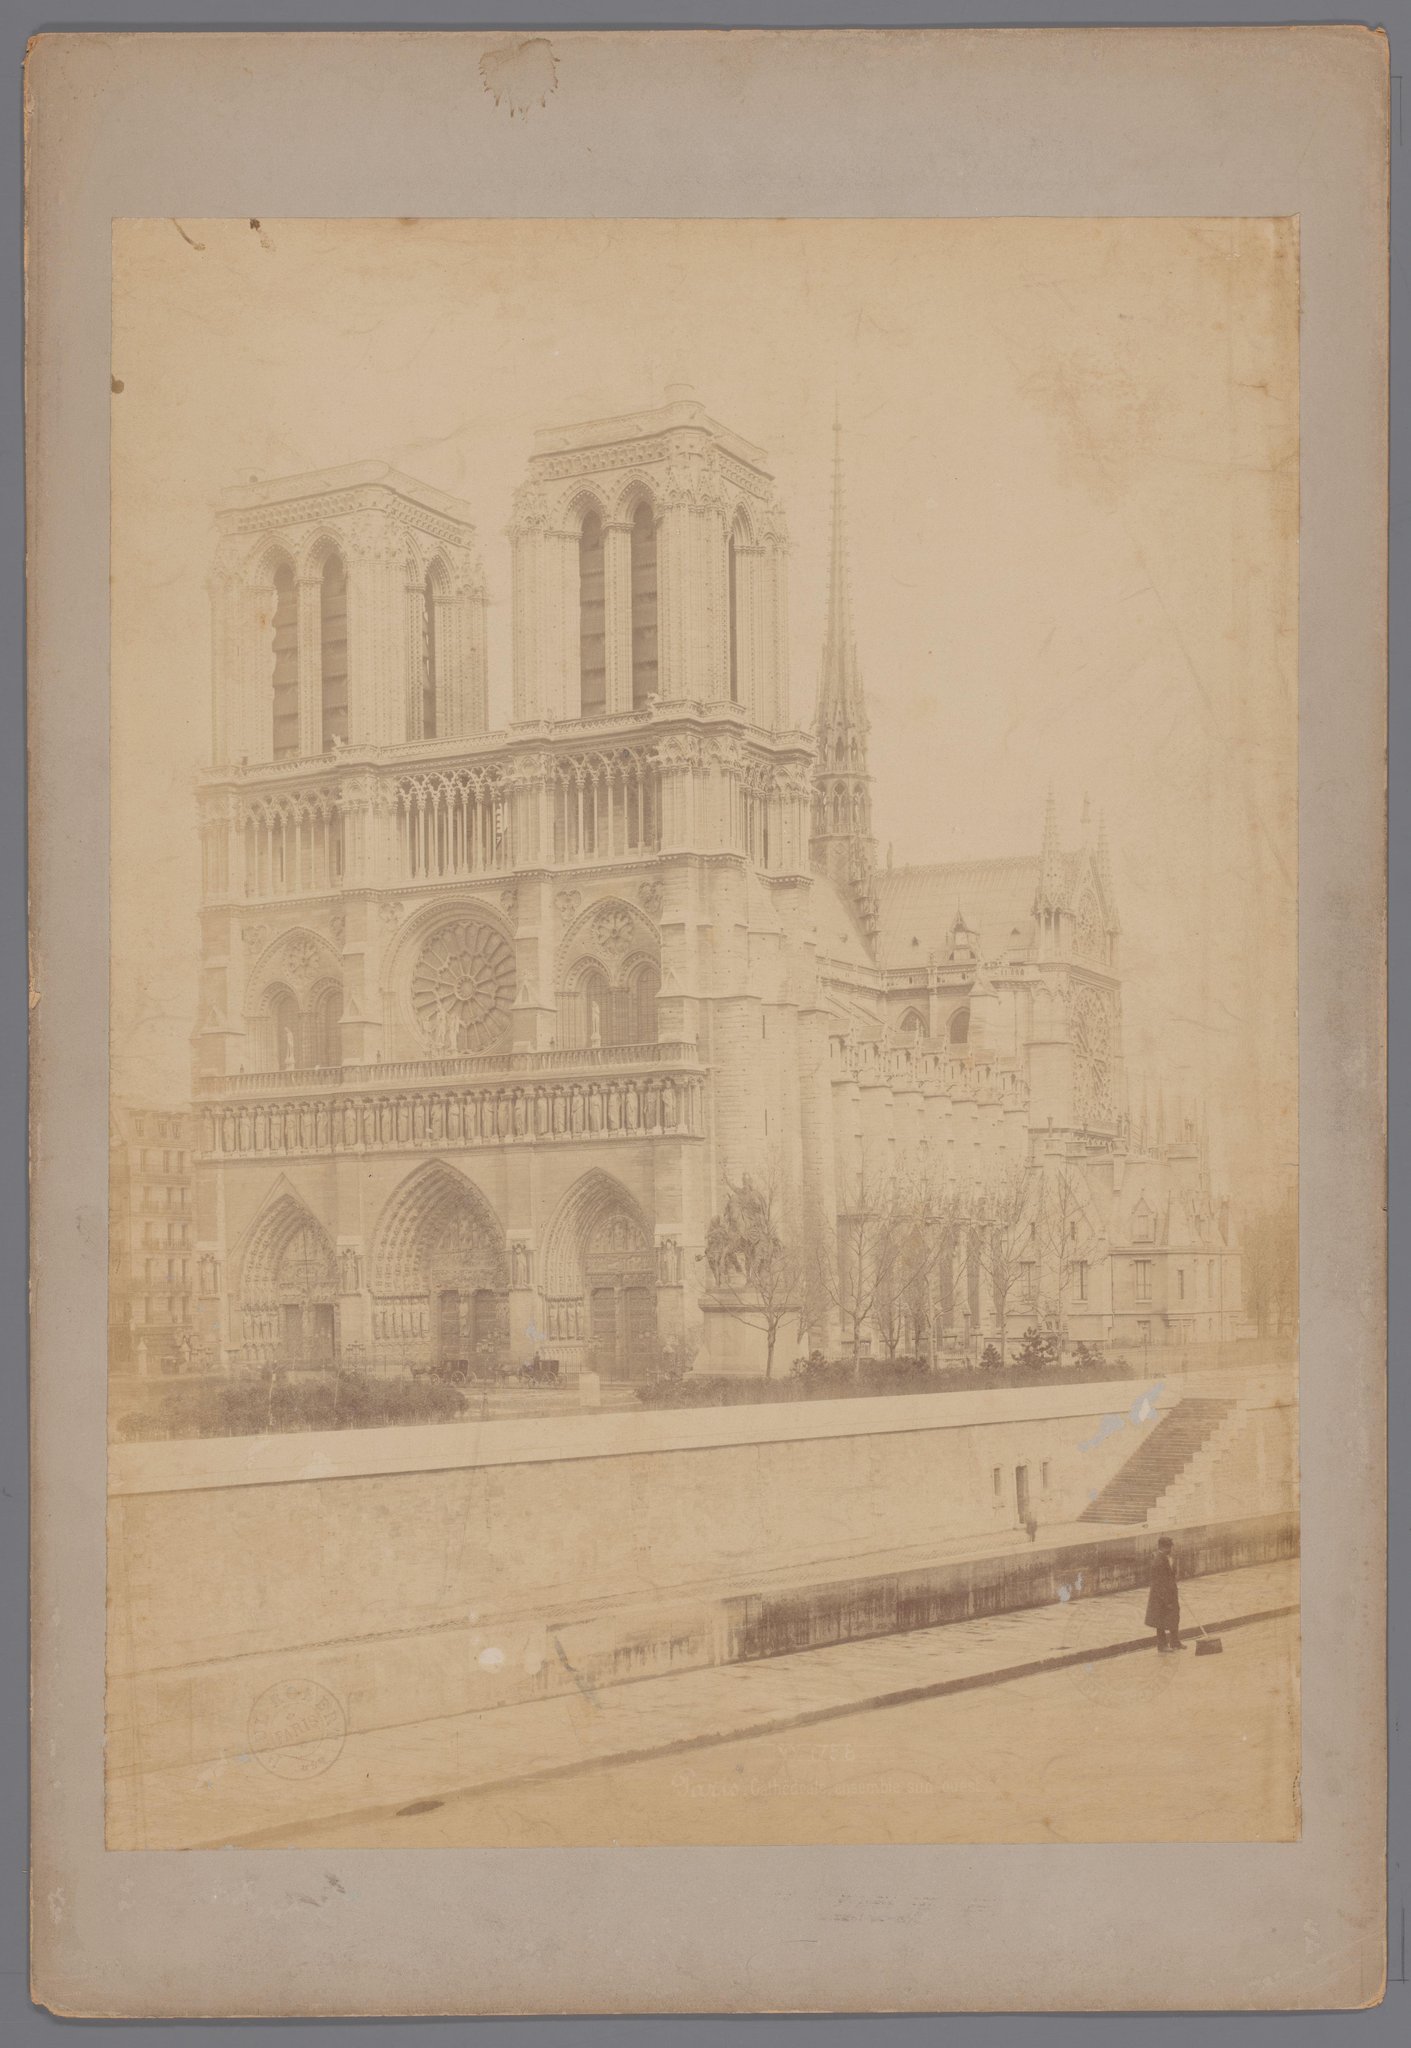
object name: photograph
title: Notre-Dame, gezien vanuit zuid-westen, Parijs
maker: paul robert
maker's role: fotograaf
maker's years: 1865-1905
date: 1890-1900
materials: cardboard, photographic support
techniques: albumen print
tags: notre-dame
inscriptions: check stamp: ‘[?]’, inscription: ‘No. 1758//Paris, Cathédrale, ensemble sud ouest.’, check stamp: ‘PAUL ROBERT//PARIS’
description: Notre-Dame, gezien vanuit zuid-westen, Parijs, Frankrijk.